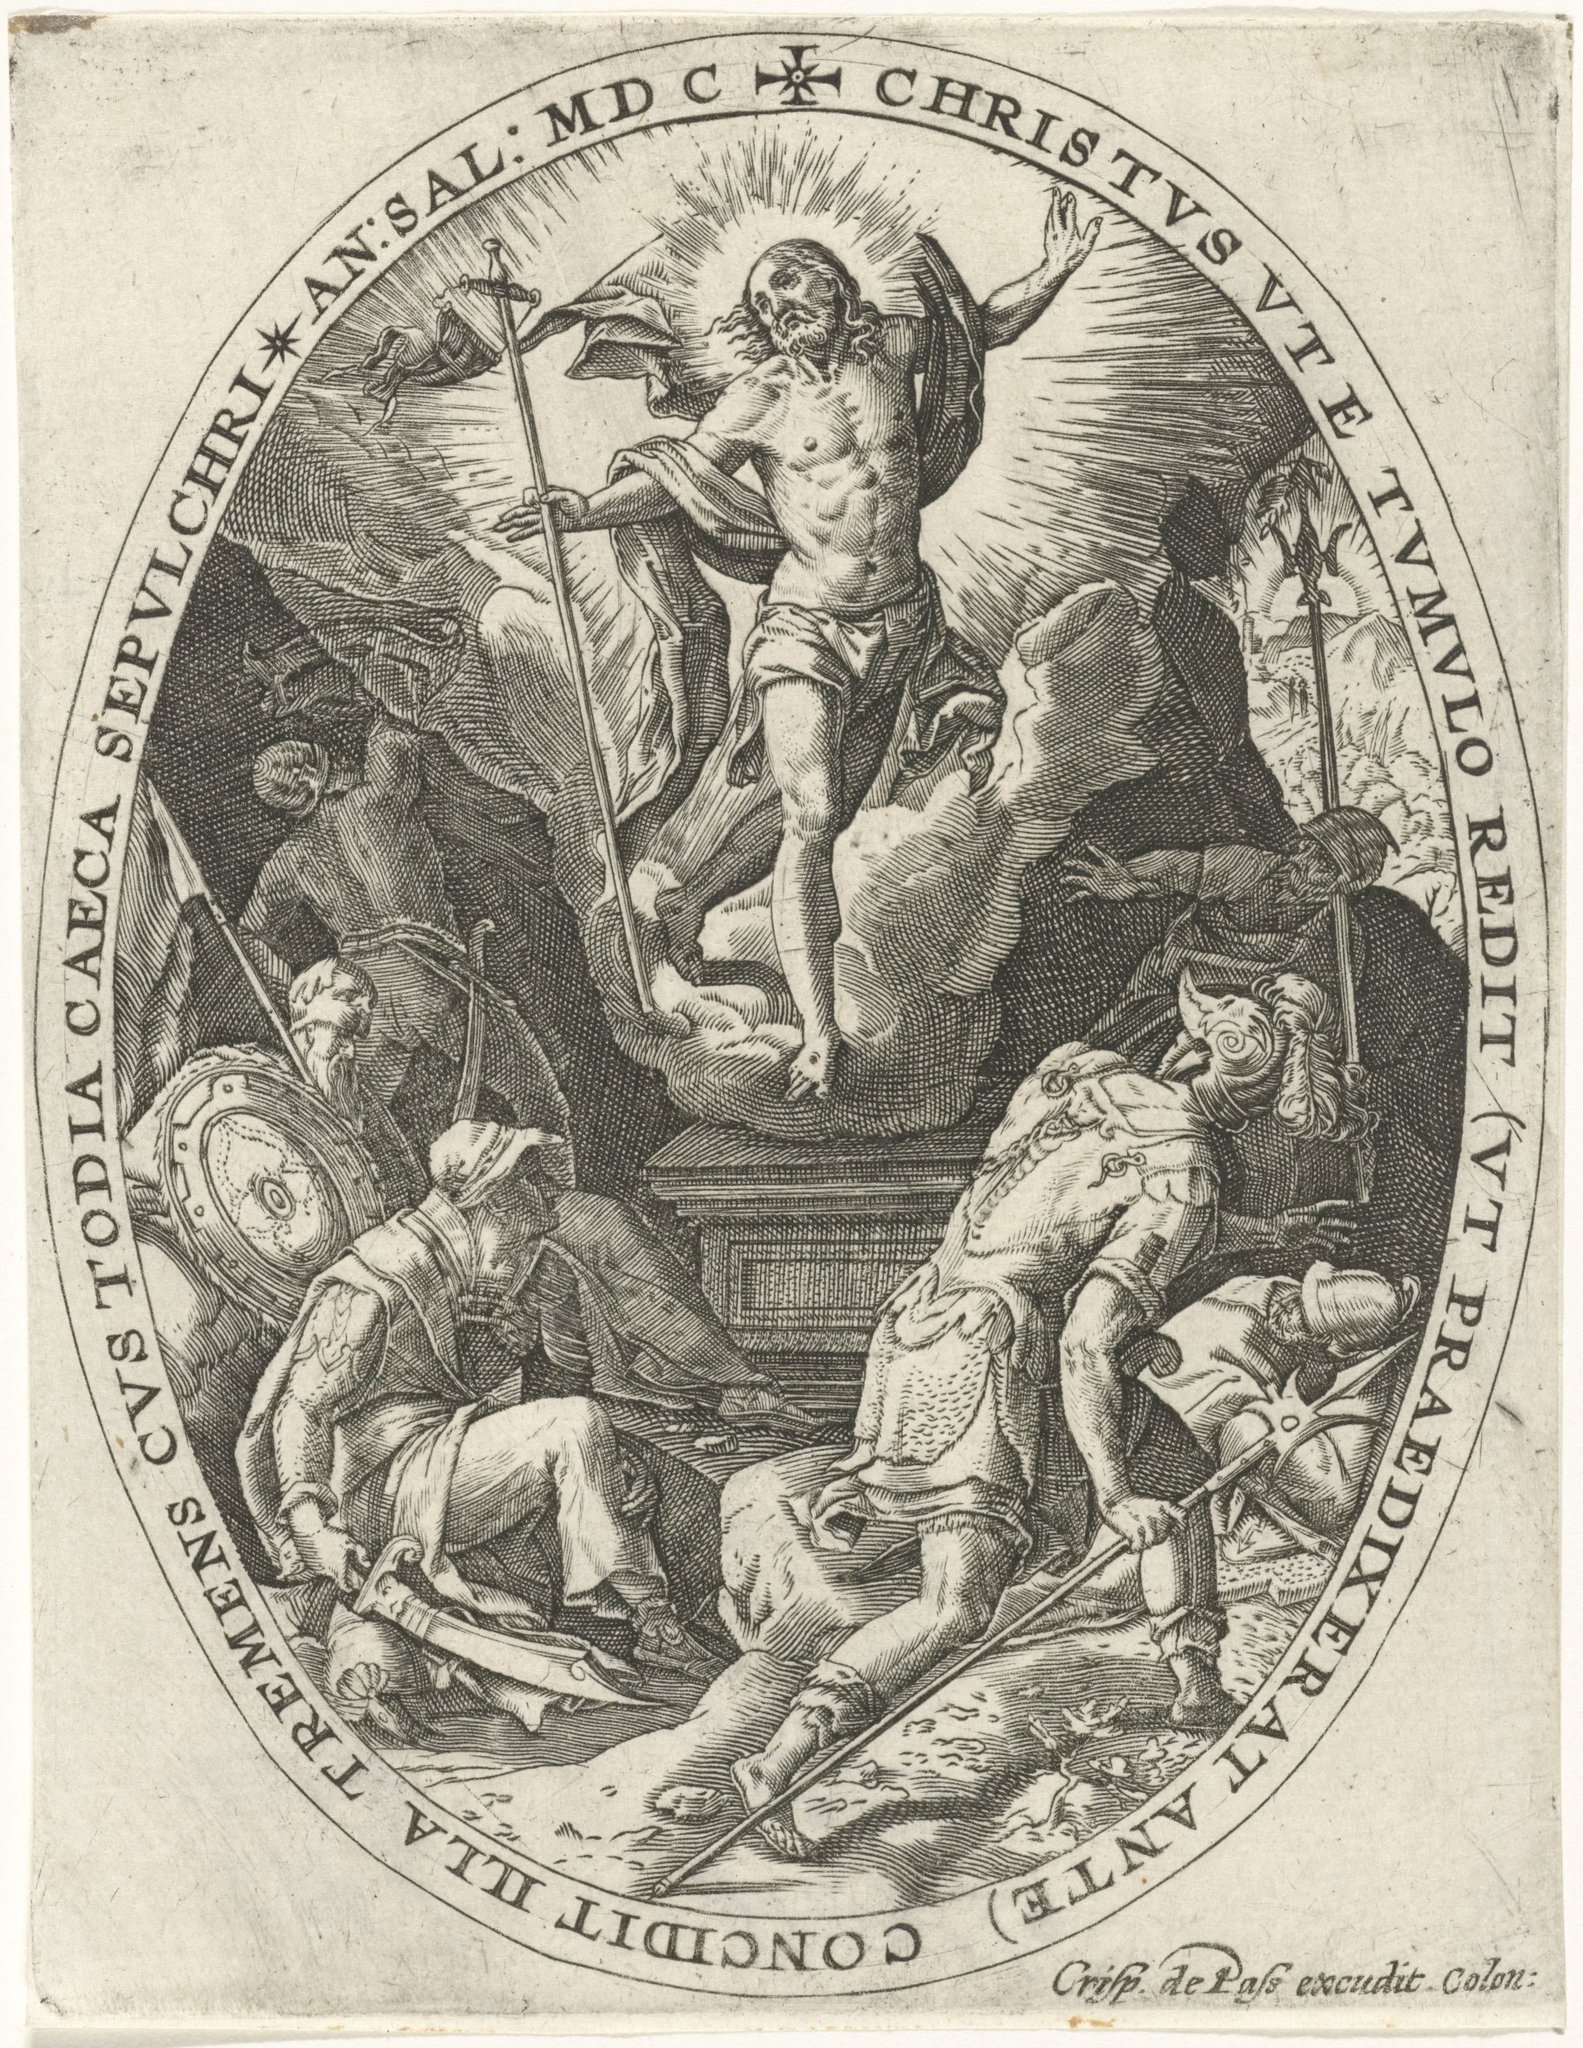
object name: print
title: Passio Domini nostri Jesu Christi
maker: crispijn van de passe (i)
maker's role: draughtsman, print maker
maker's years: 1564-1637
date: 1600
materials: paper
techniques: engraving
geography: cologne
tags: resurrection of christ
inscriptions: collector's mark: Lugt 2542, collector's mark: Lugt 2228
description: Christus verrijst uit zijn graf. De soldaten die rond het graf liggen schrikken wakker en vluchten. De voorstelling is gevat in een ovale omlijsting met een randschrift in het Latijn. Prent uit een serie met de passie van Christus.